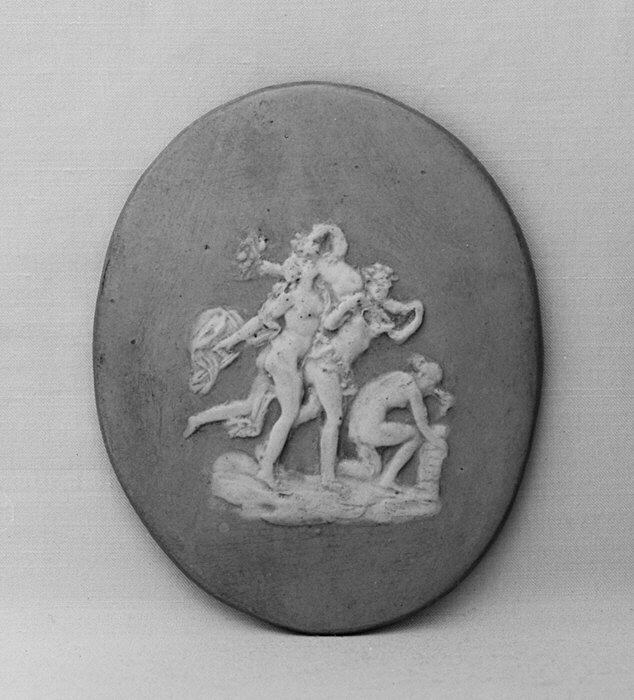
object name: medallion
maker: sèvres manufactory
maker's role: manufactory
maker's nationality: french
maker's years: 1740-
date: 1701-1800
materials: porcelain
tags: human figures